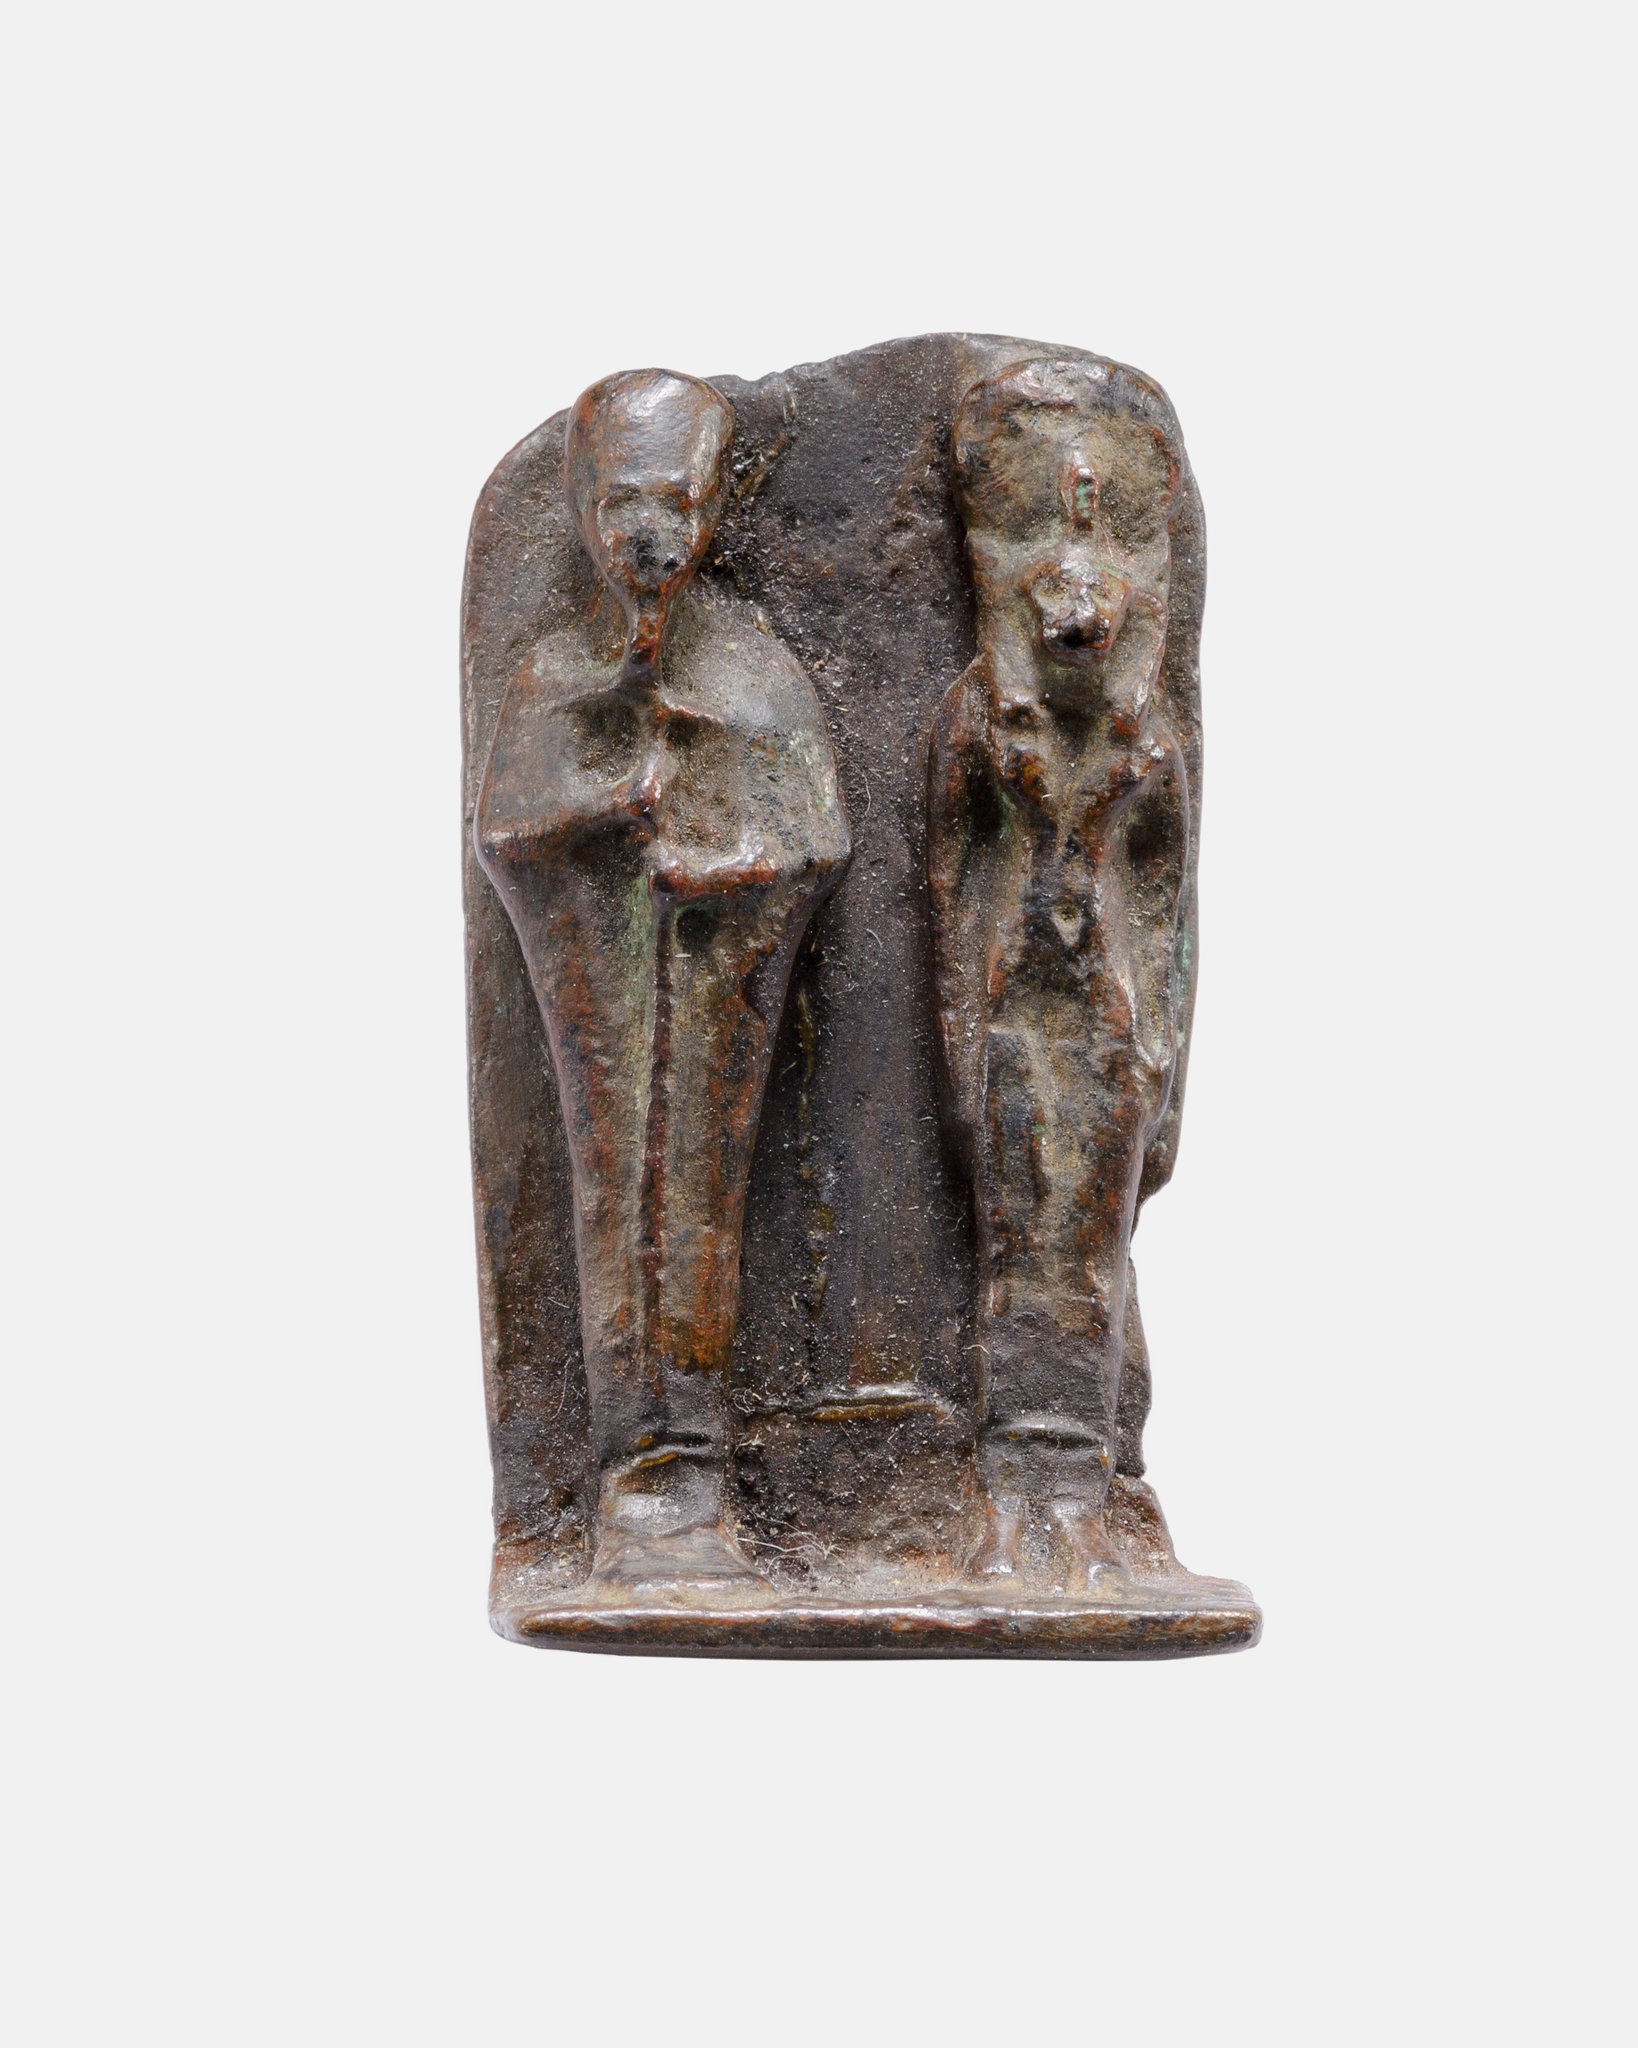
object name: amulet plaque, ptah, sakhmet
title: Ptah and Sakhmet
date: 664-630 BCE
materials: metal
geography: egypt